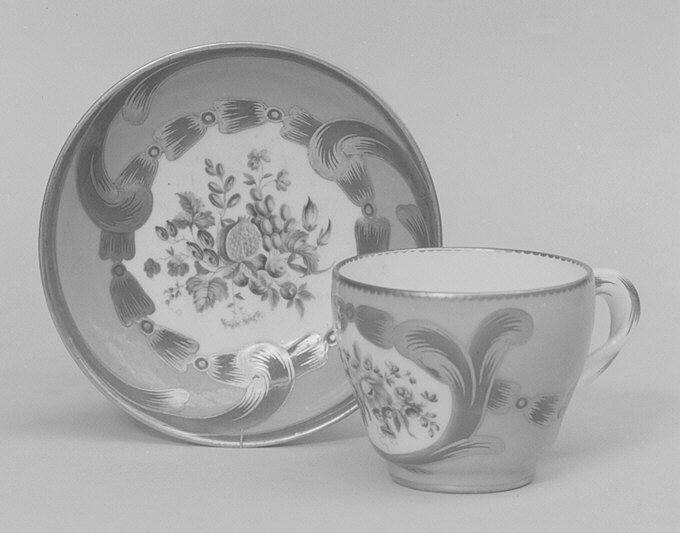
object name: saucer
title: Saucer (gobelet Hébert et soucoupe) (part of a service)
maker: sèvres manufactory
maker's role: manufactory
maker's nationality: french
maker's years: 1740-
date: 1760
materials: soft paste porcelain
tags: flowers